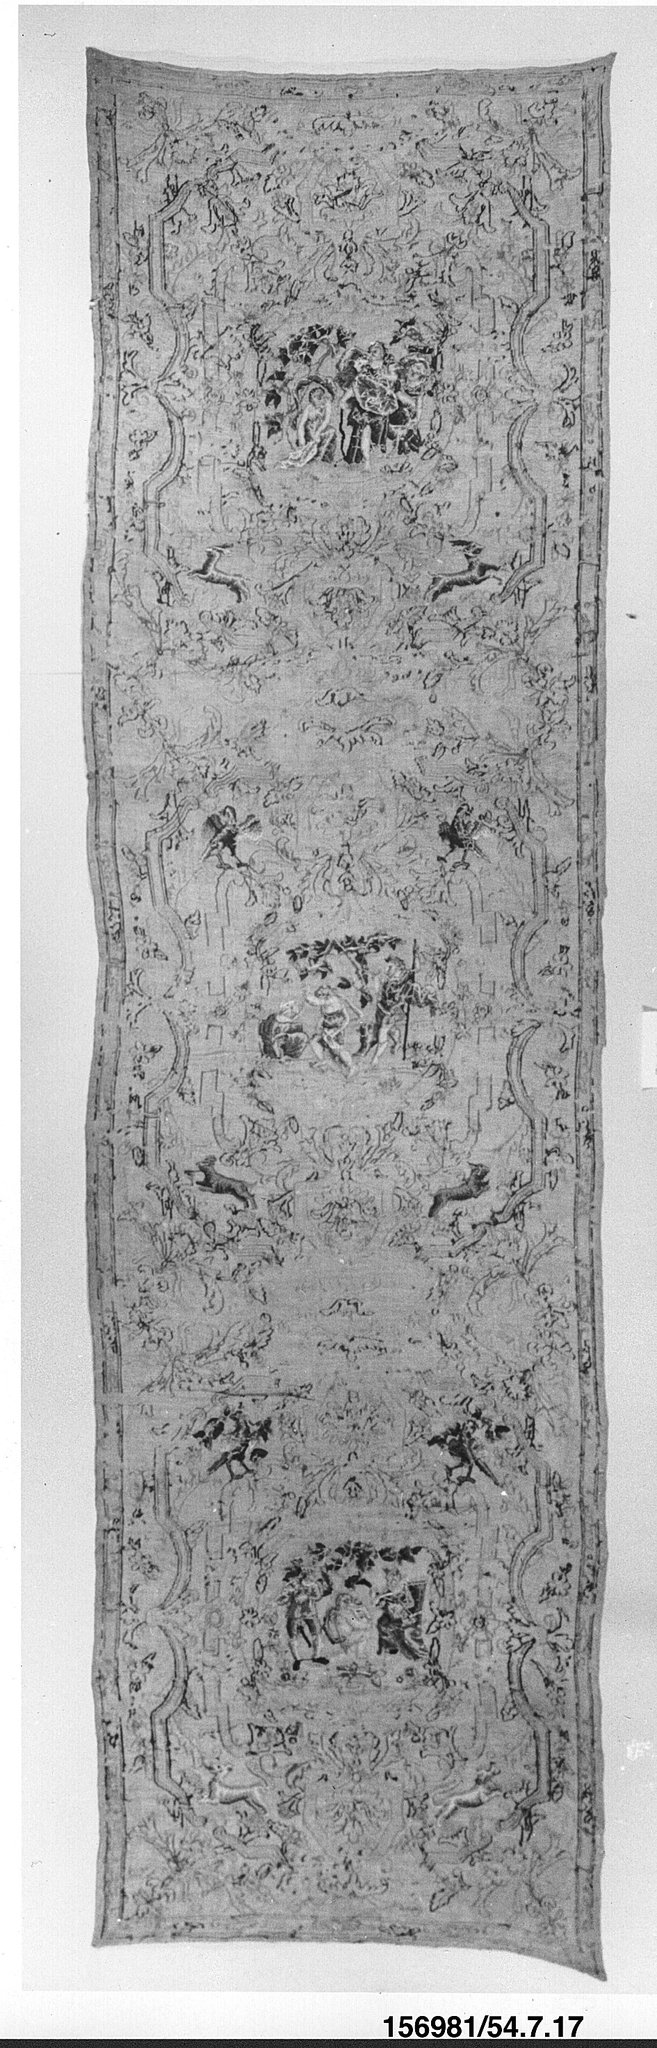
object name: curtain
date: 1701-1800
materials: canvas, silk, wool